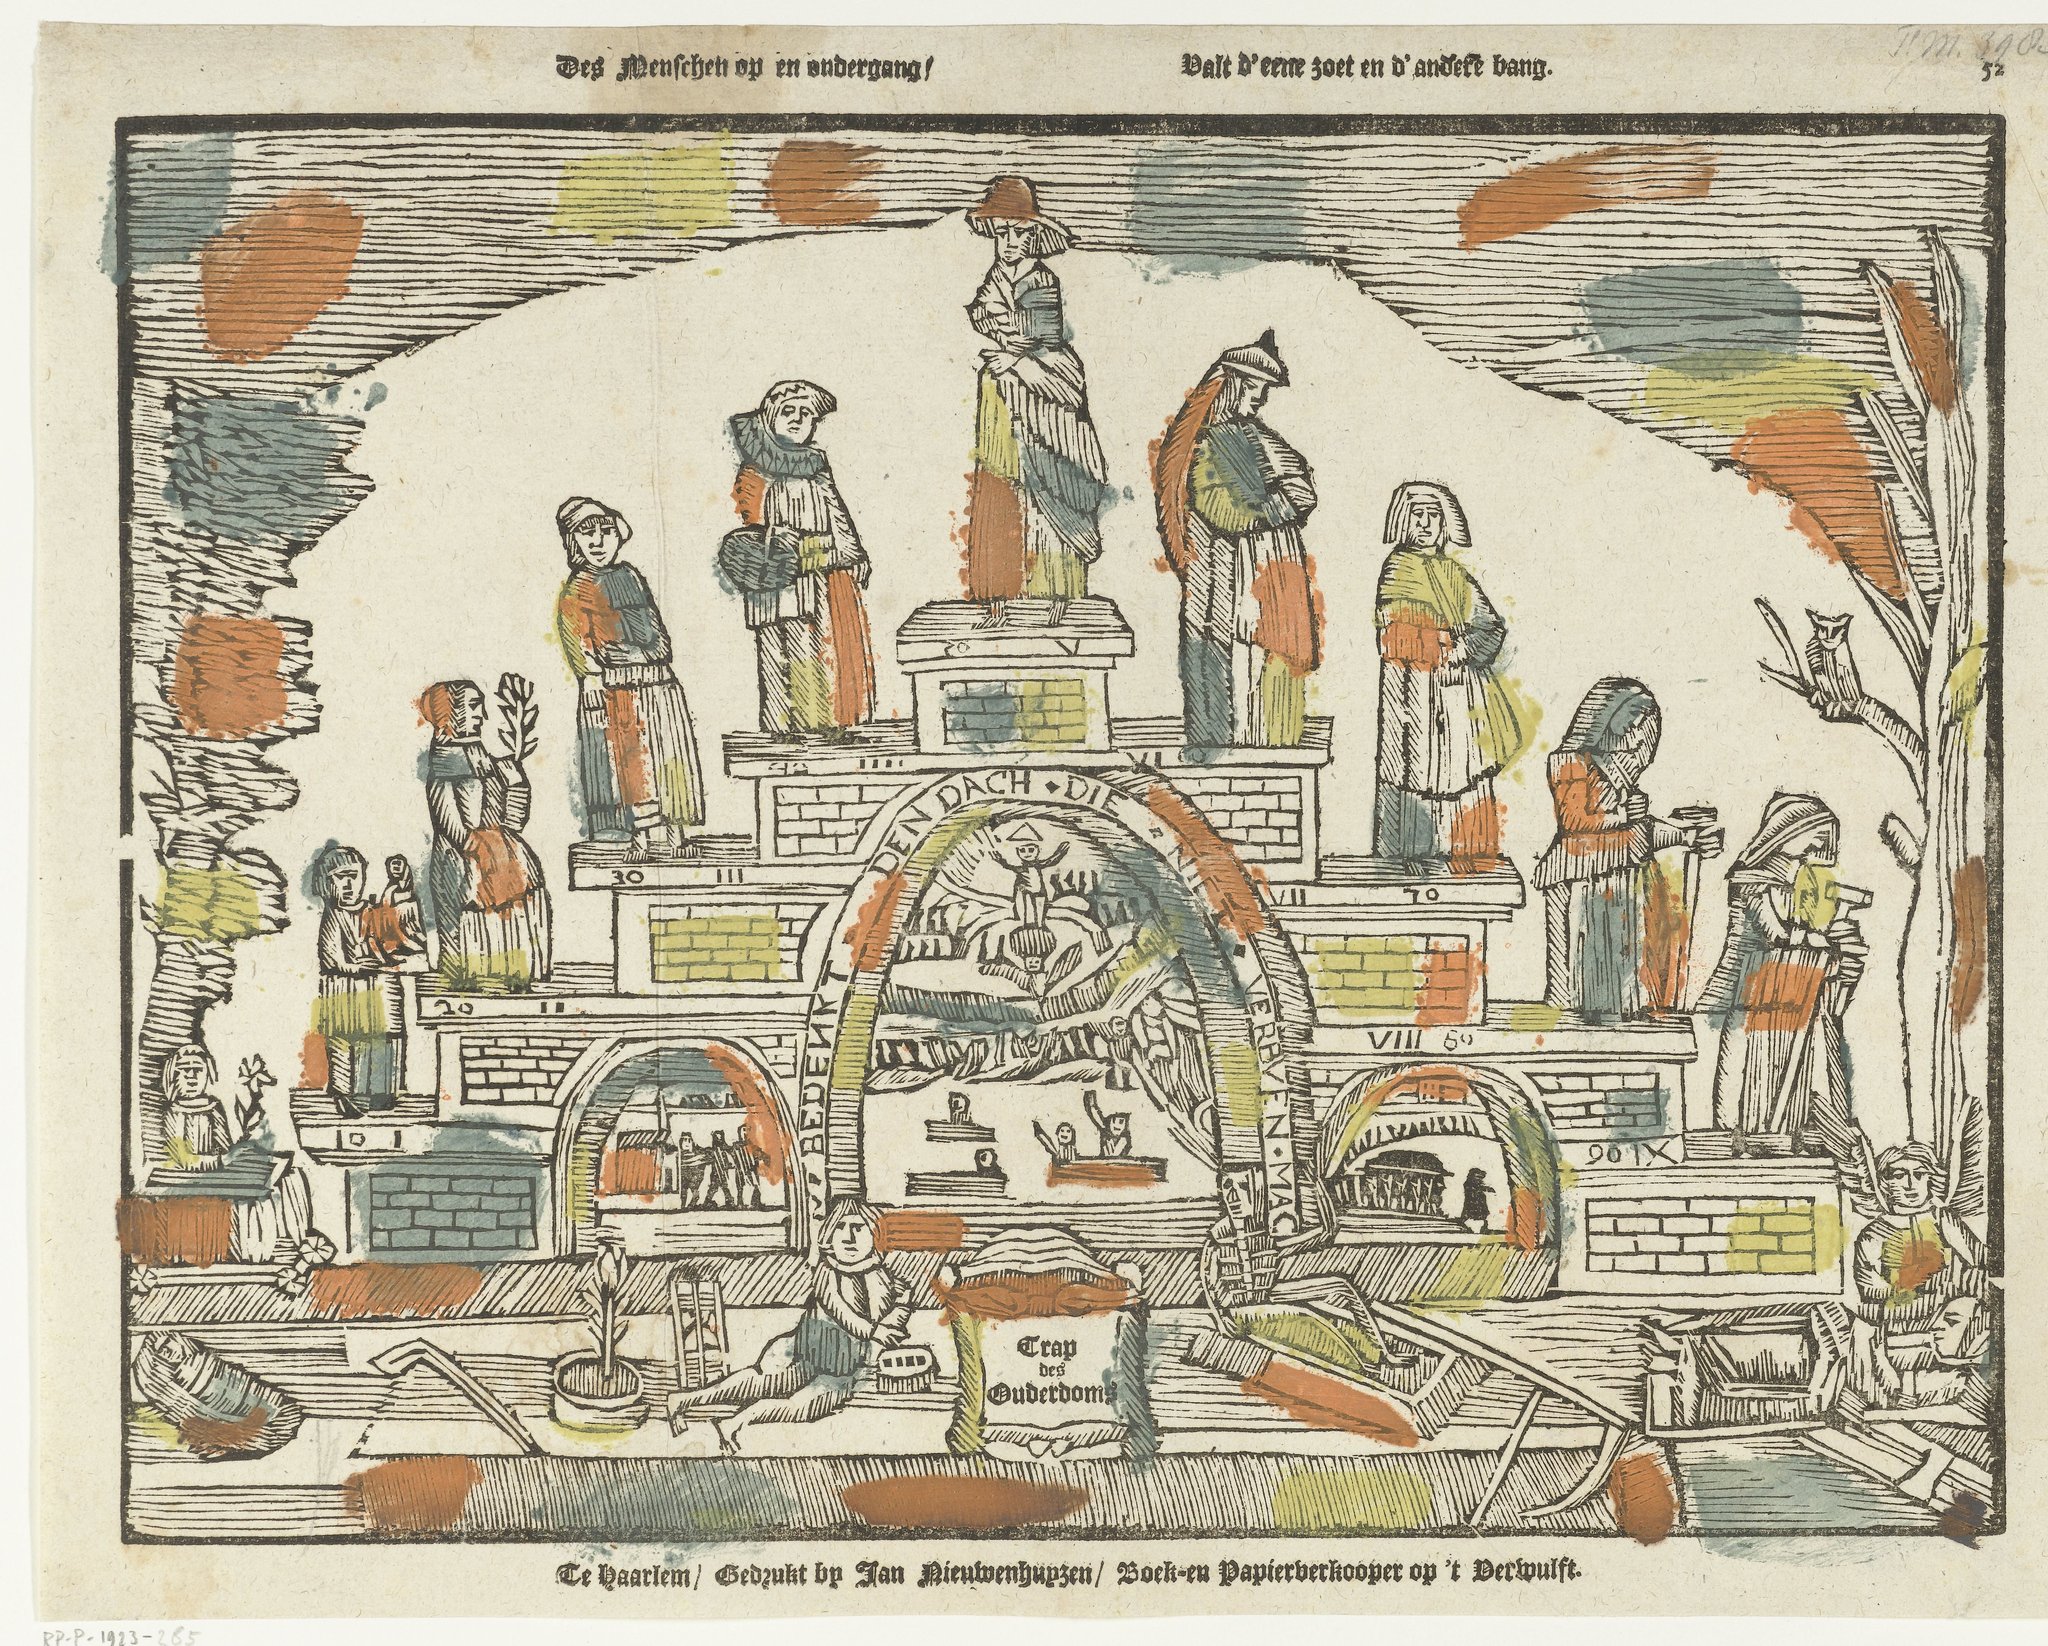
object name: popular print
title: Trap des ouderdoms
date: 1743-1758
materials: paper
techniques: colour, letterpress printing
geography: haarlem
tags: last judgement, the ages of man represented by a staircase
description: Een trap des ouderdoms: een vrouwentrap. Op de treden van de trap, in de vorm van een brug, staan vrouwen in de leeftijd van 0 tot 100 jaar. Onder de brug een voorstelling van het Laatste Oordeel. Linksvoor een putto en rechtsvoor de dood. Aan weerszijden van de voorstelling een boom. Genummerd rechtsboven: 52.